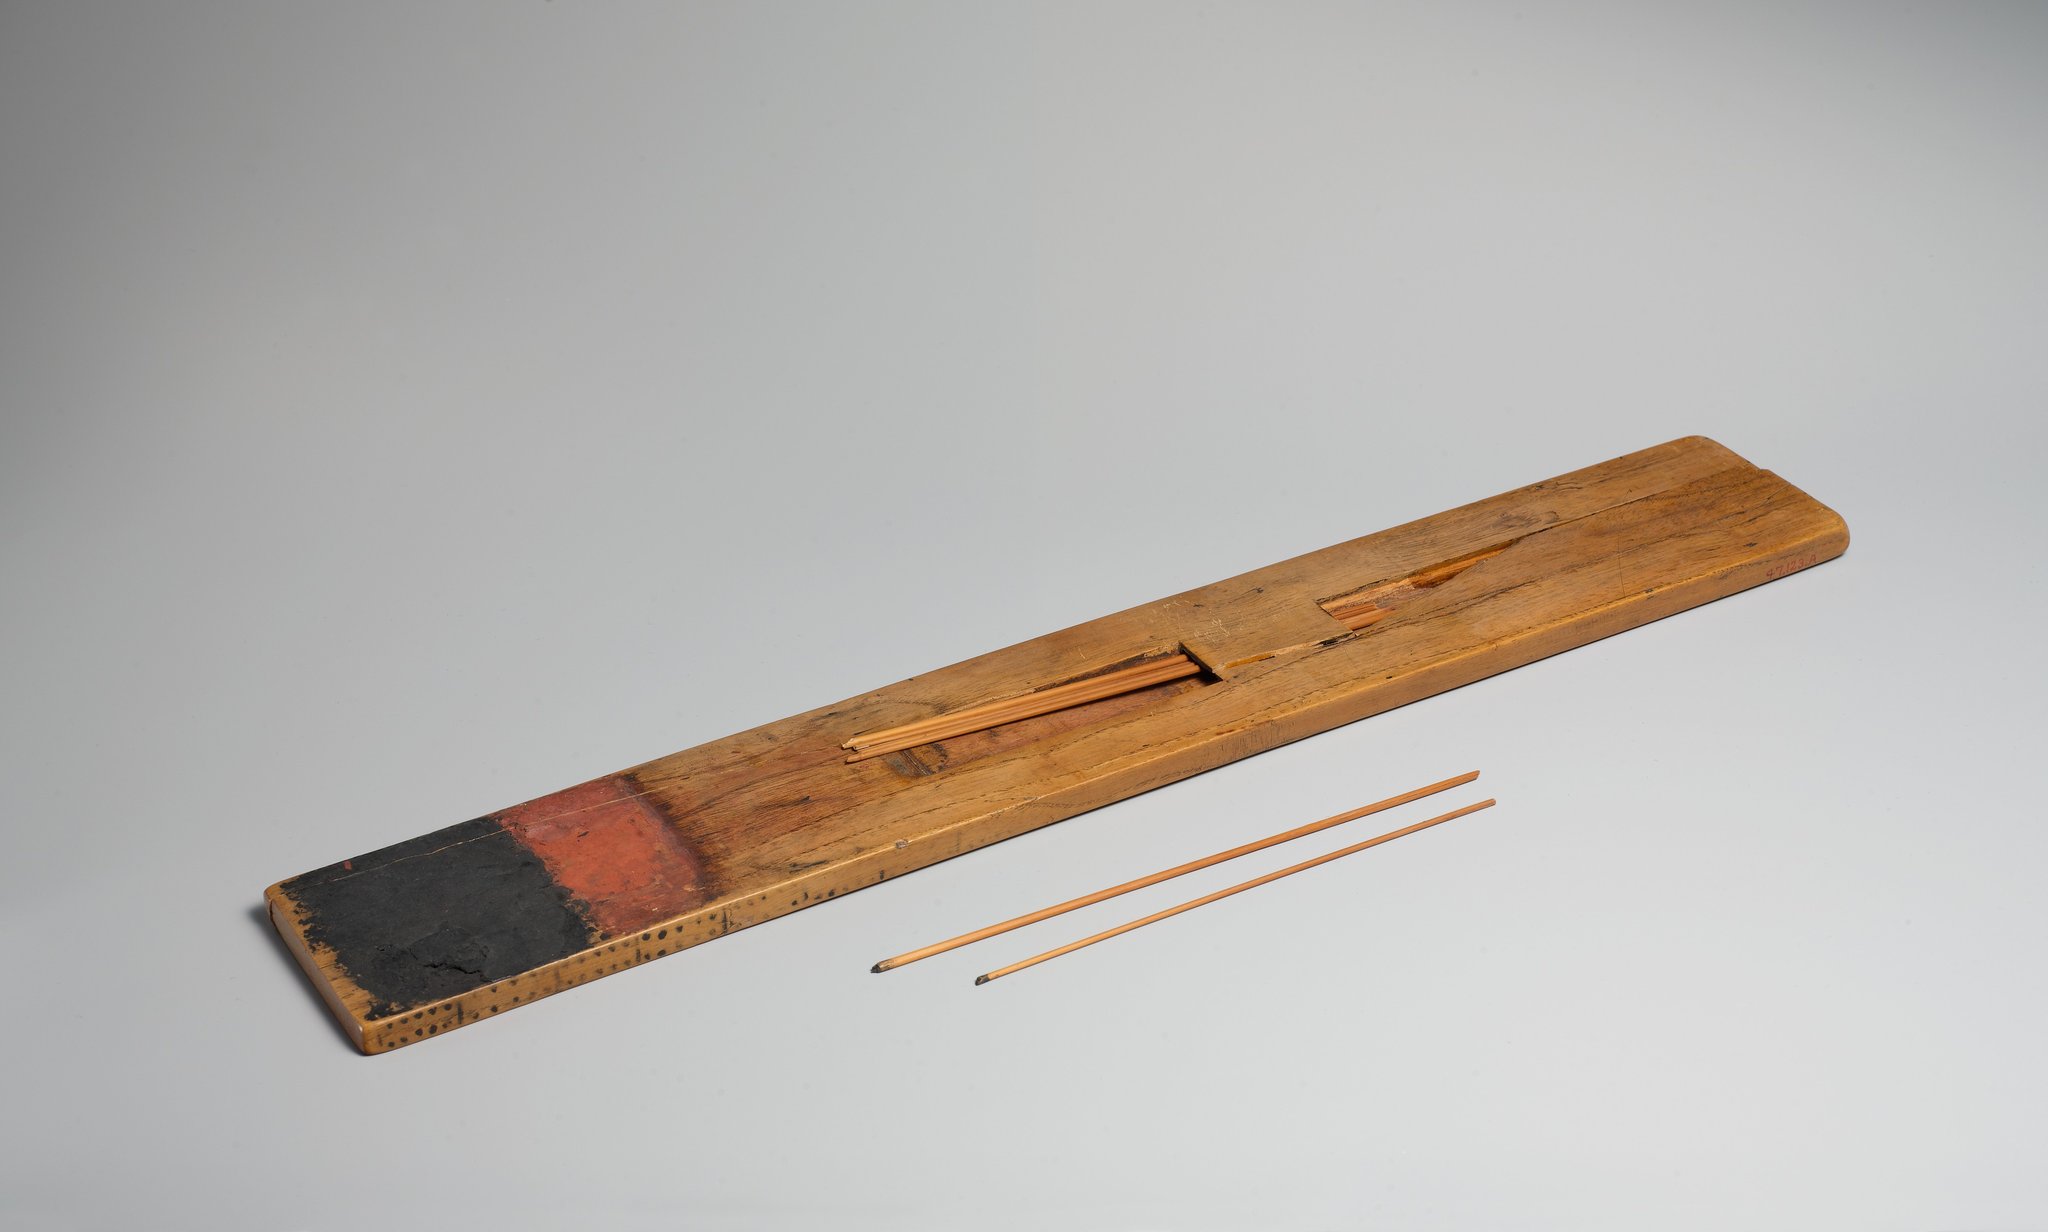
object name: palette, brush, scribe, smendes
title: Palette inscribed for Smendes (II), High Priest of Amun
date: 1045-992 BCE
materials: ink, wood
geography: upper egypt, thebes